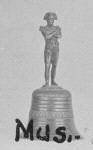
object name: handbell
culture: european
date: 1801-1900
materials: metal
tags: men